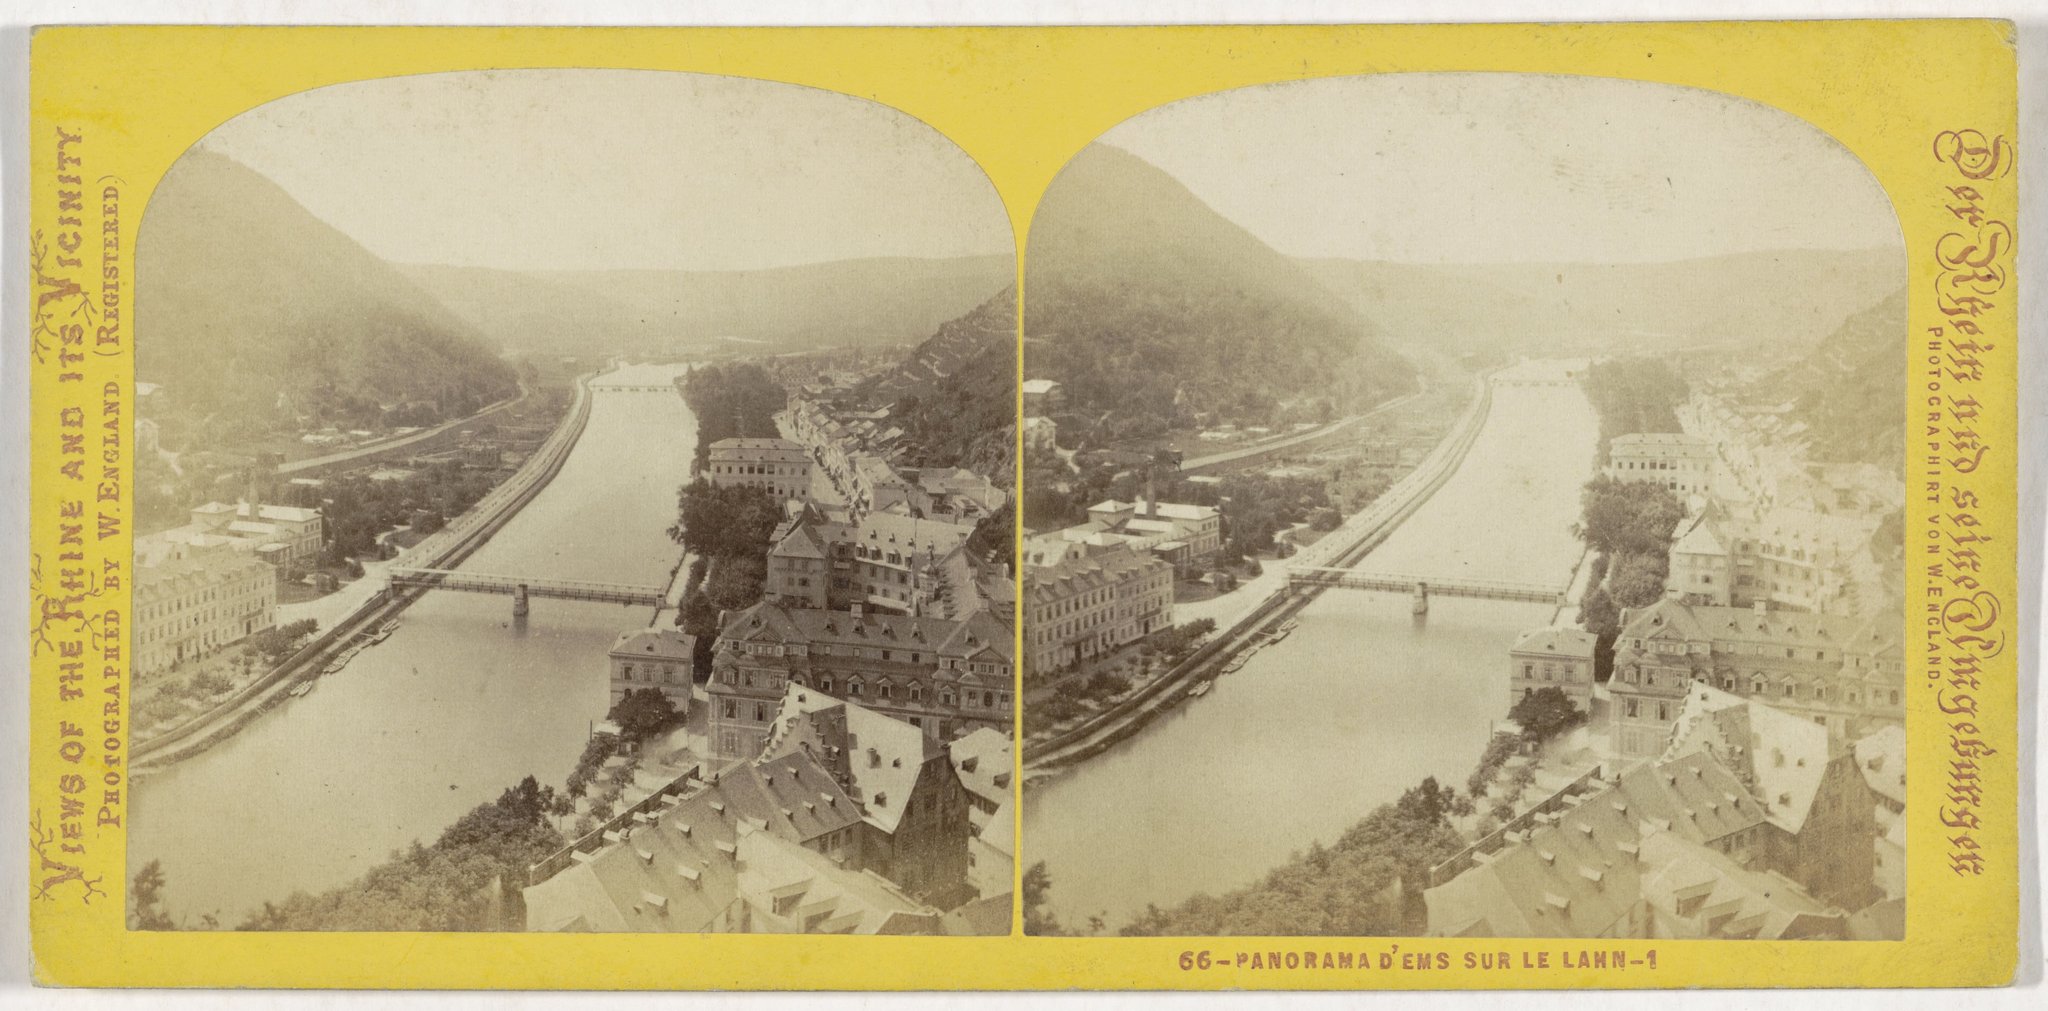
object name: stereograph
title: Gezicht op Bad Ems, Duitsland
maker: william england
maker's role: fotograaf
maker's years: 1816-1896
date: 1867-1868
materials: cardboard, paper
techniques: albumen print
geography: bad ems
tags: river, prospect of city, town panorama, silhouette of city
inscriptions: inscription: ‘(Registered)’, number: ‘66’